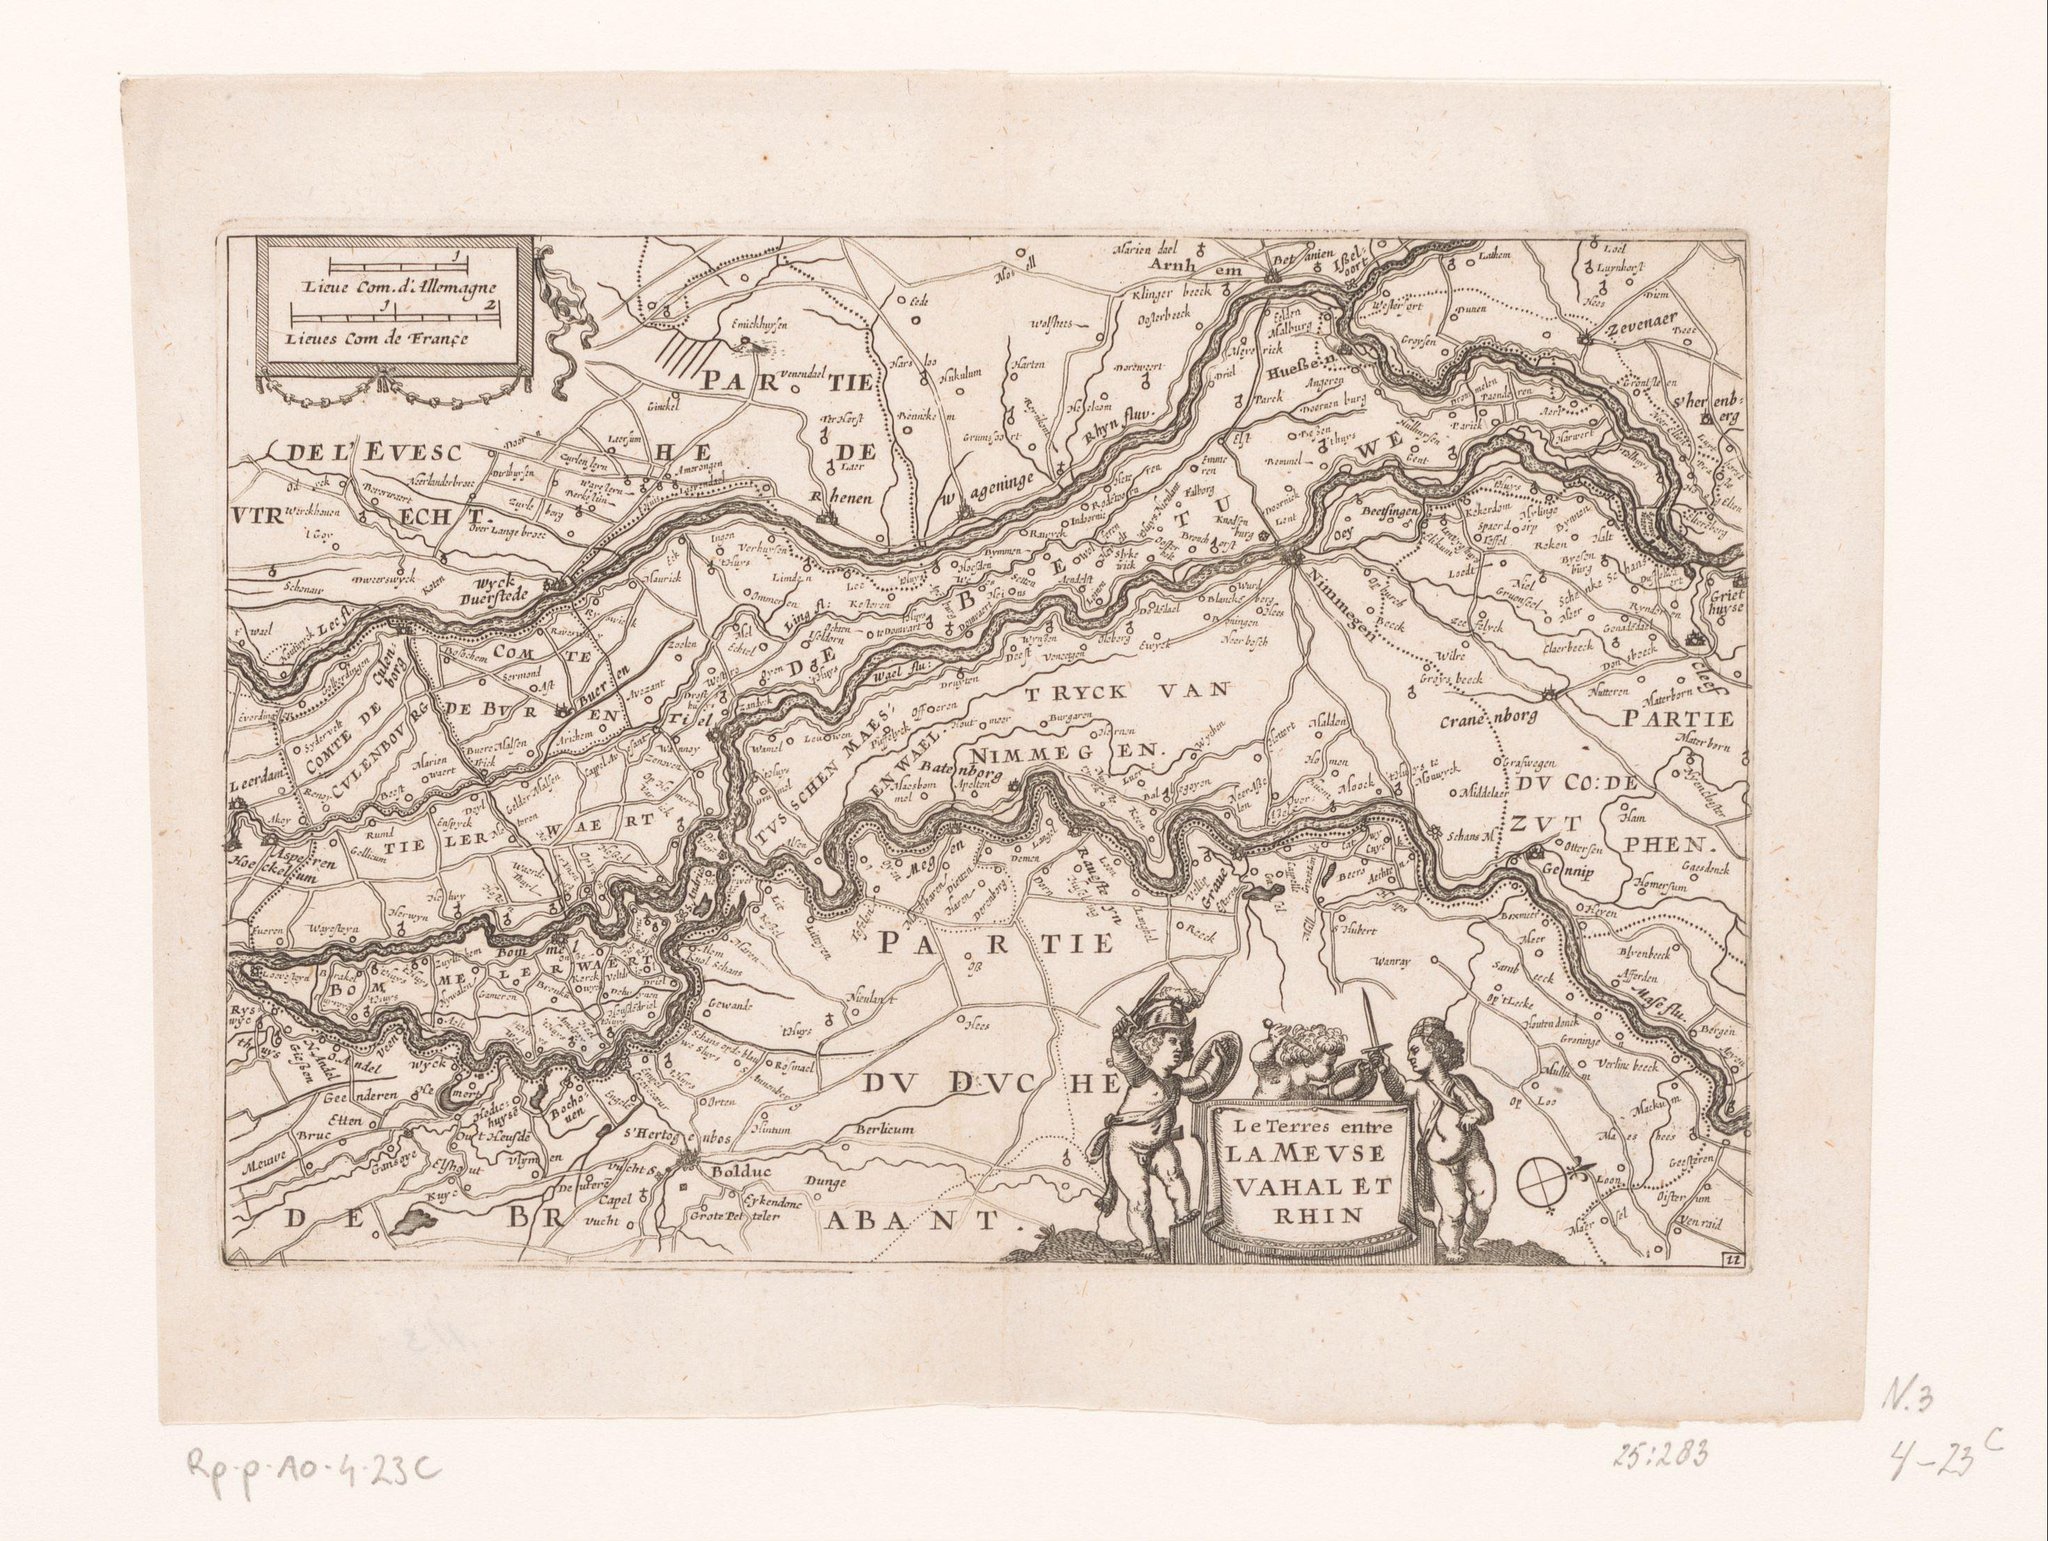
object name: print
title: Les terres entre la Meuse Vahal et Rhin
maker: Anonymous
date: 1635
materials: paper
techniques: engraving, etching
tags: maps of separate countries or regions, river, gelderland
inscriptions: collector's mark: Lugt 2228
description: Rechtsonder te titelcartouche. Linksboven een cartouche met twee schaalstokken: 1 Lieue com. d'Allemagne / 2 Lieues Com de France. Rechtsonder genummerd: 11.